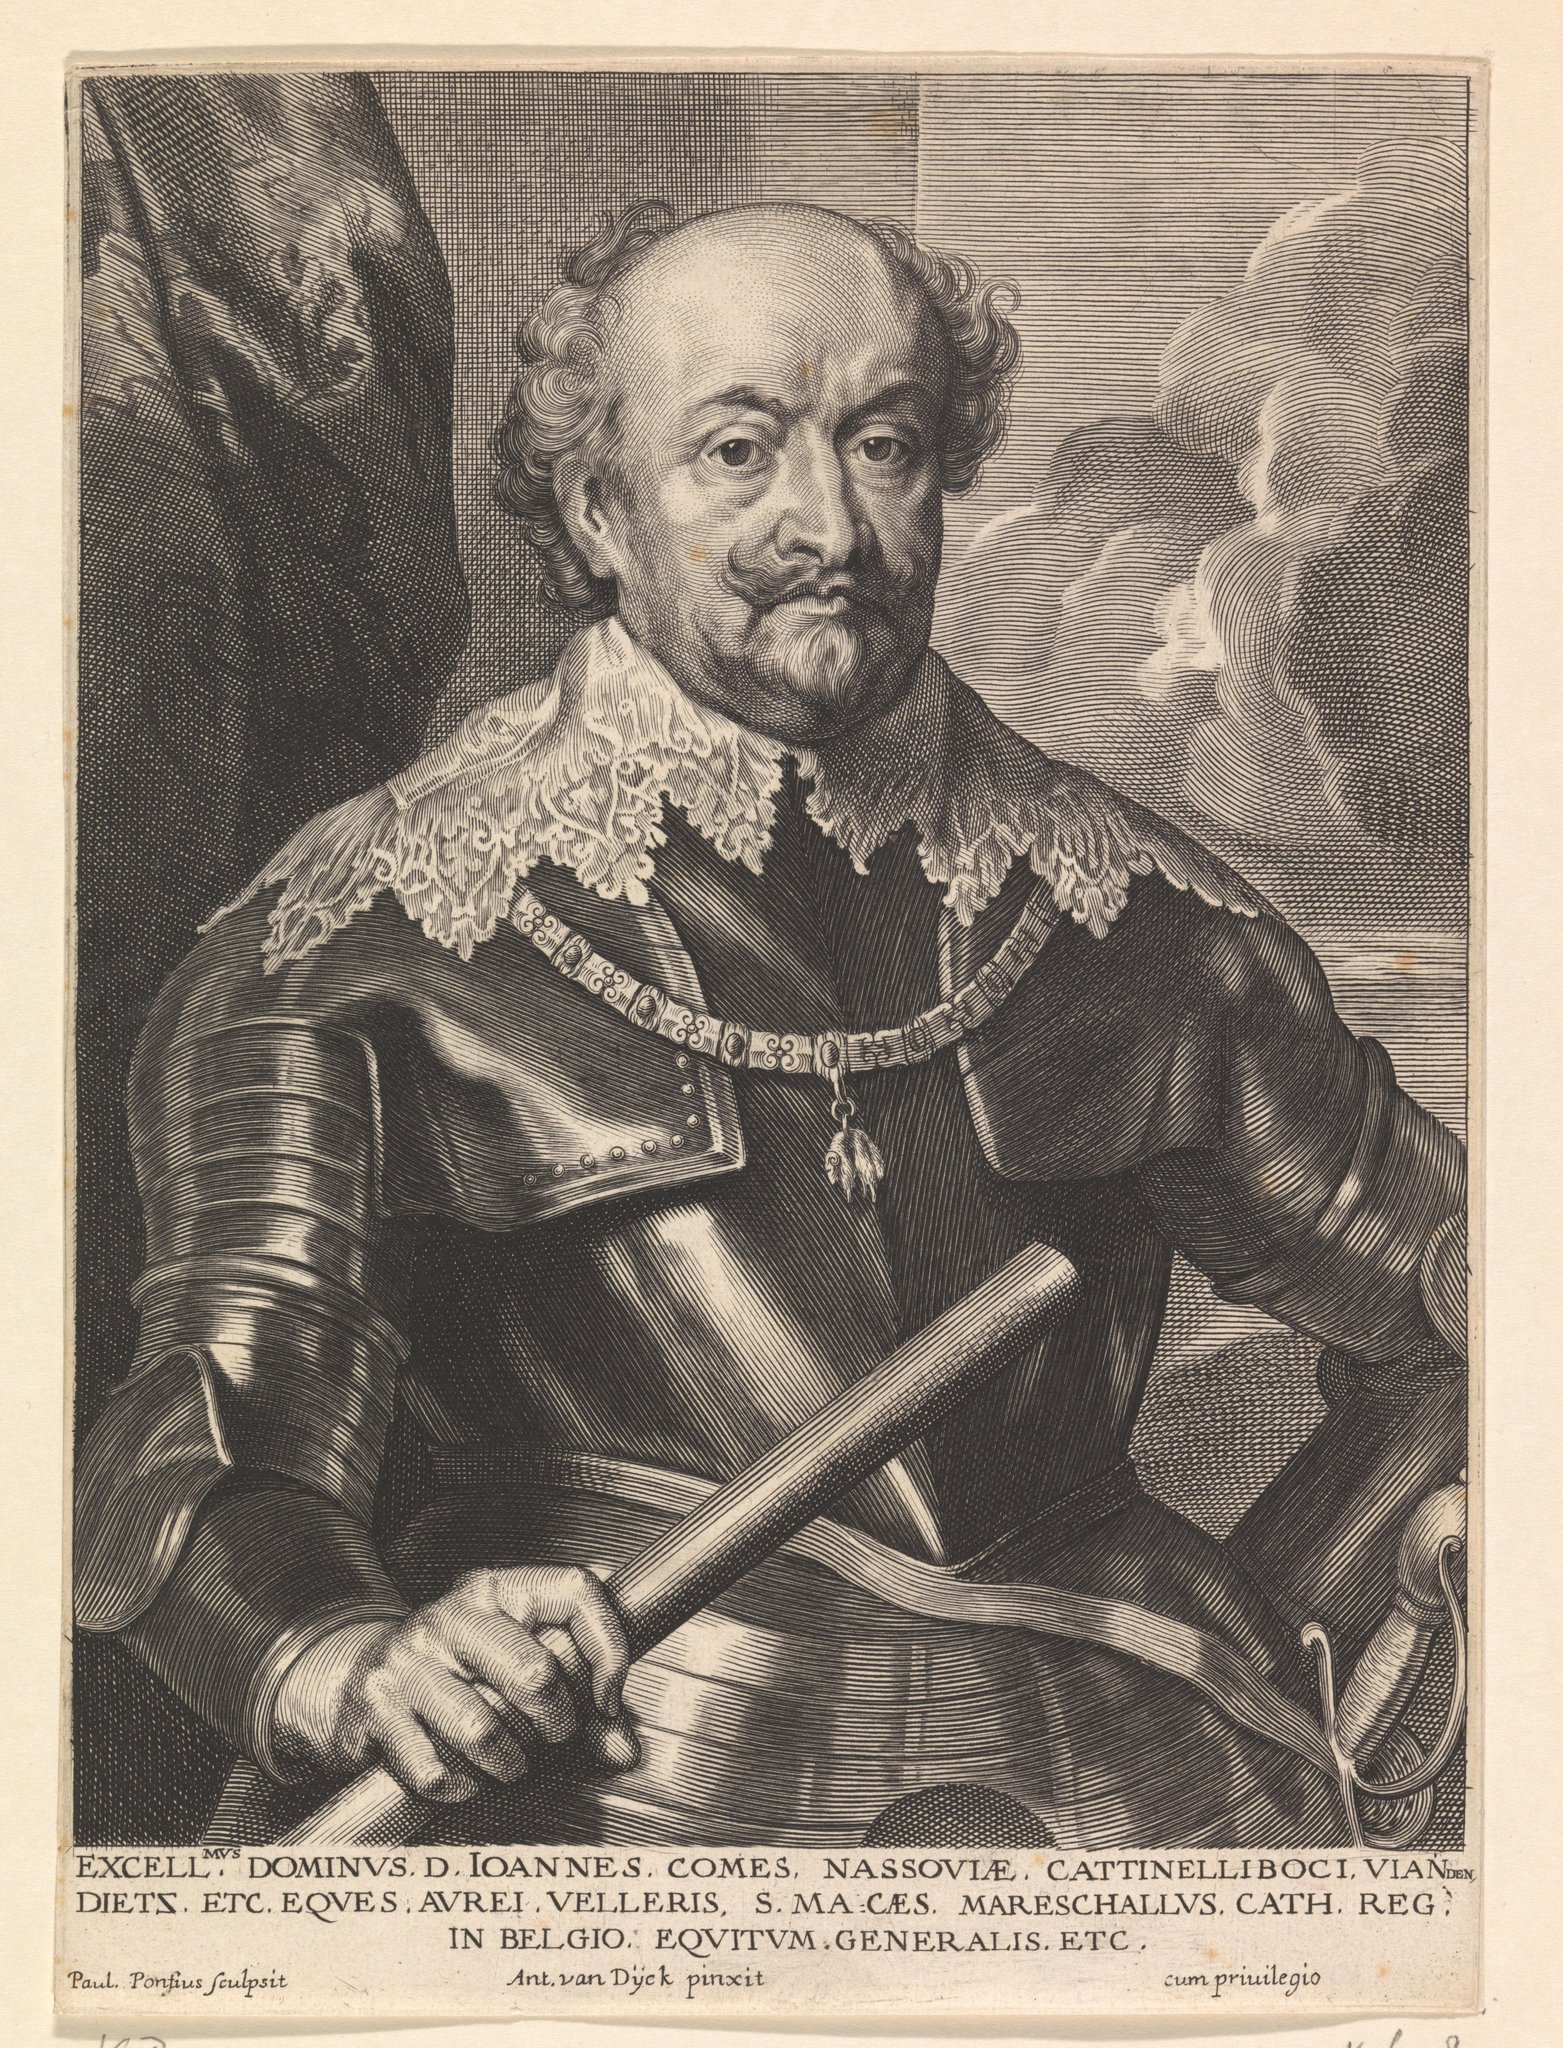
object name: print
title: Portret van Johan VIII, graaf van Nassau-Siegen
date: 1616-1657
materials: paper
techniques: engraving, etching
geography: antwerp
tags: knighthood order of the golden fleece - insignia of a knighthood order, e.g.: badge, chain (with name of order)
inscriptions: collector's mark: Lugt 240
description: De hier vermelde titel verwijst naar de hoogst verkregen titel van de geportretteerde, niet per se naar de titel die de geportretteerde op deze voorstelling draagt.